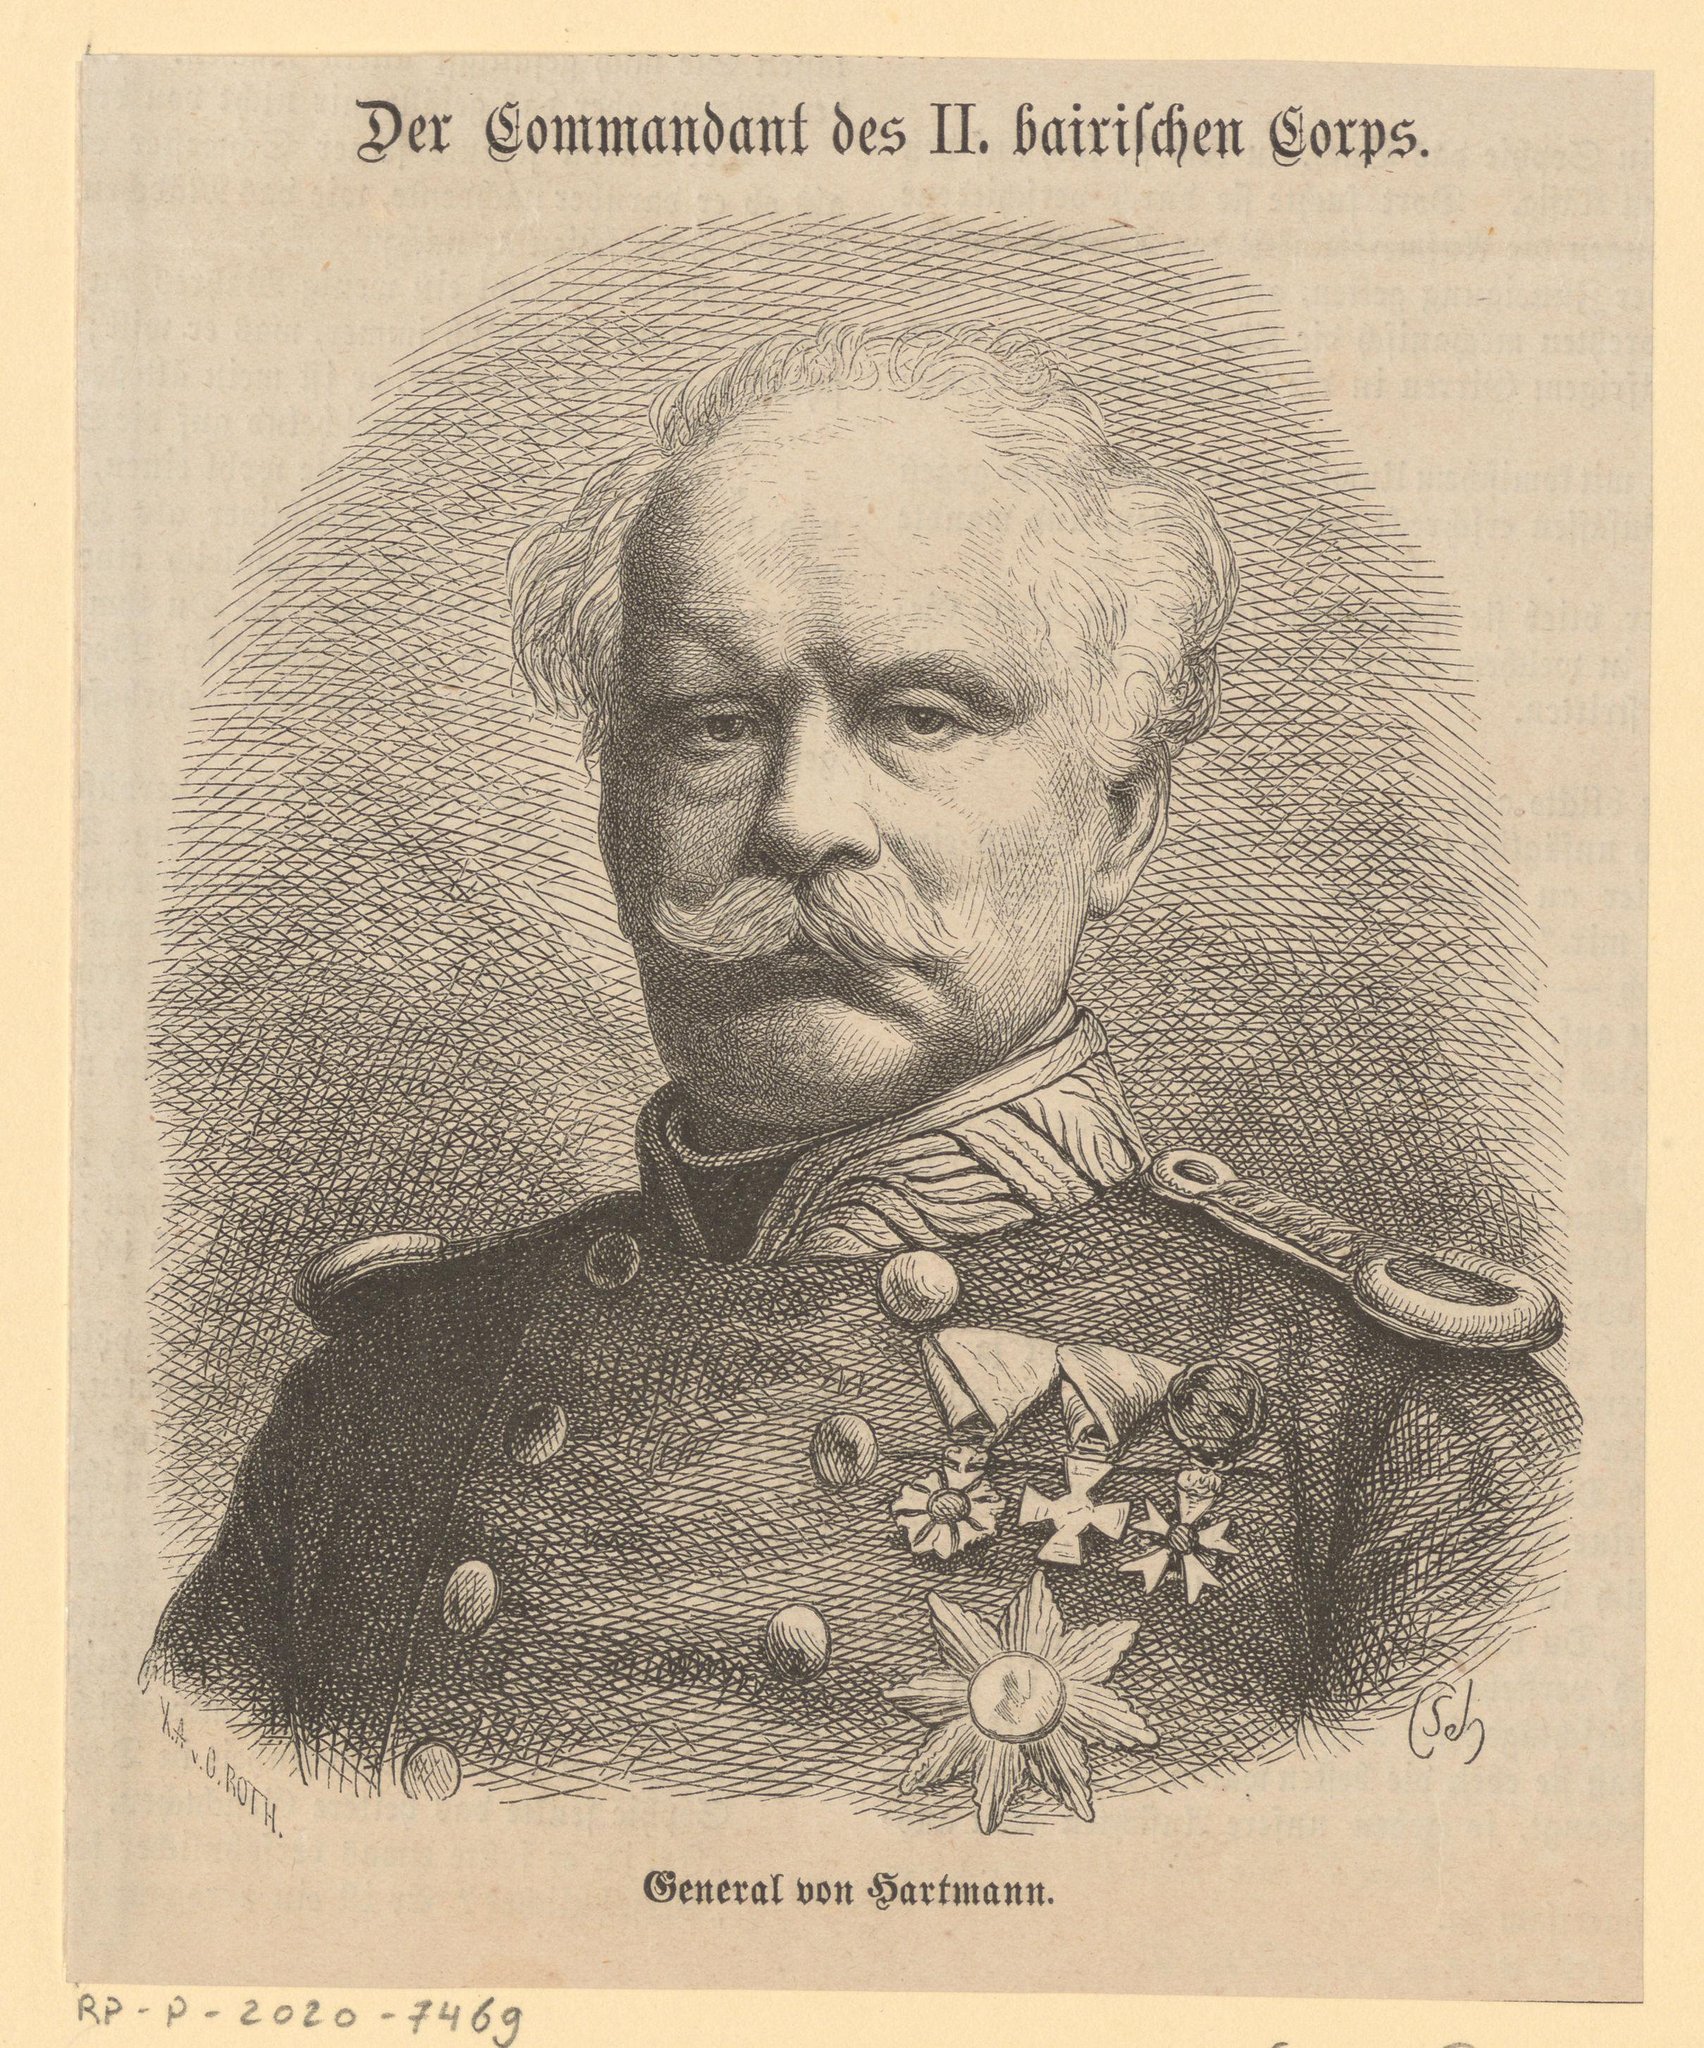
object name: print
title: Portret van Jakob von Hartmann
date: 1871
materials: paper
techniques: letterpress printing, engraving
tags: commander-in-chief, general, marshal, historical persons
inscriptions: collector's mark: ‘JVB’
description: Prent uit: Daheim 7 (1871), nr. 17, 21 januari 1871.